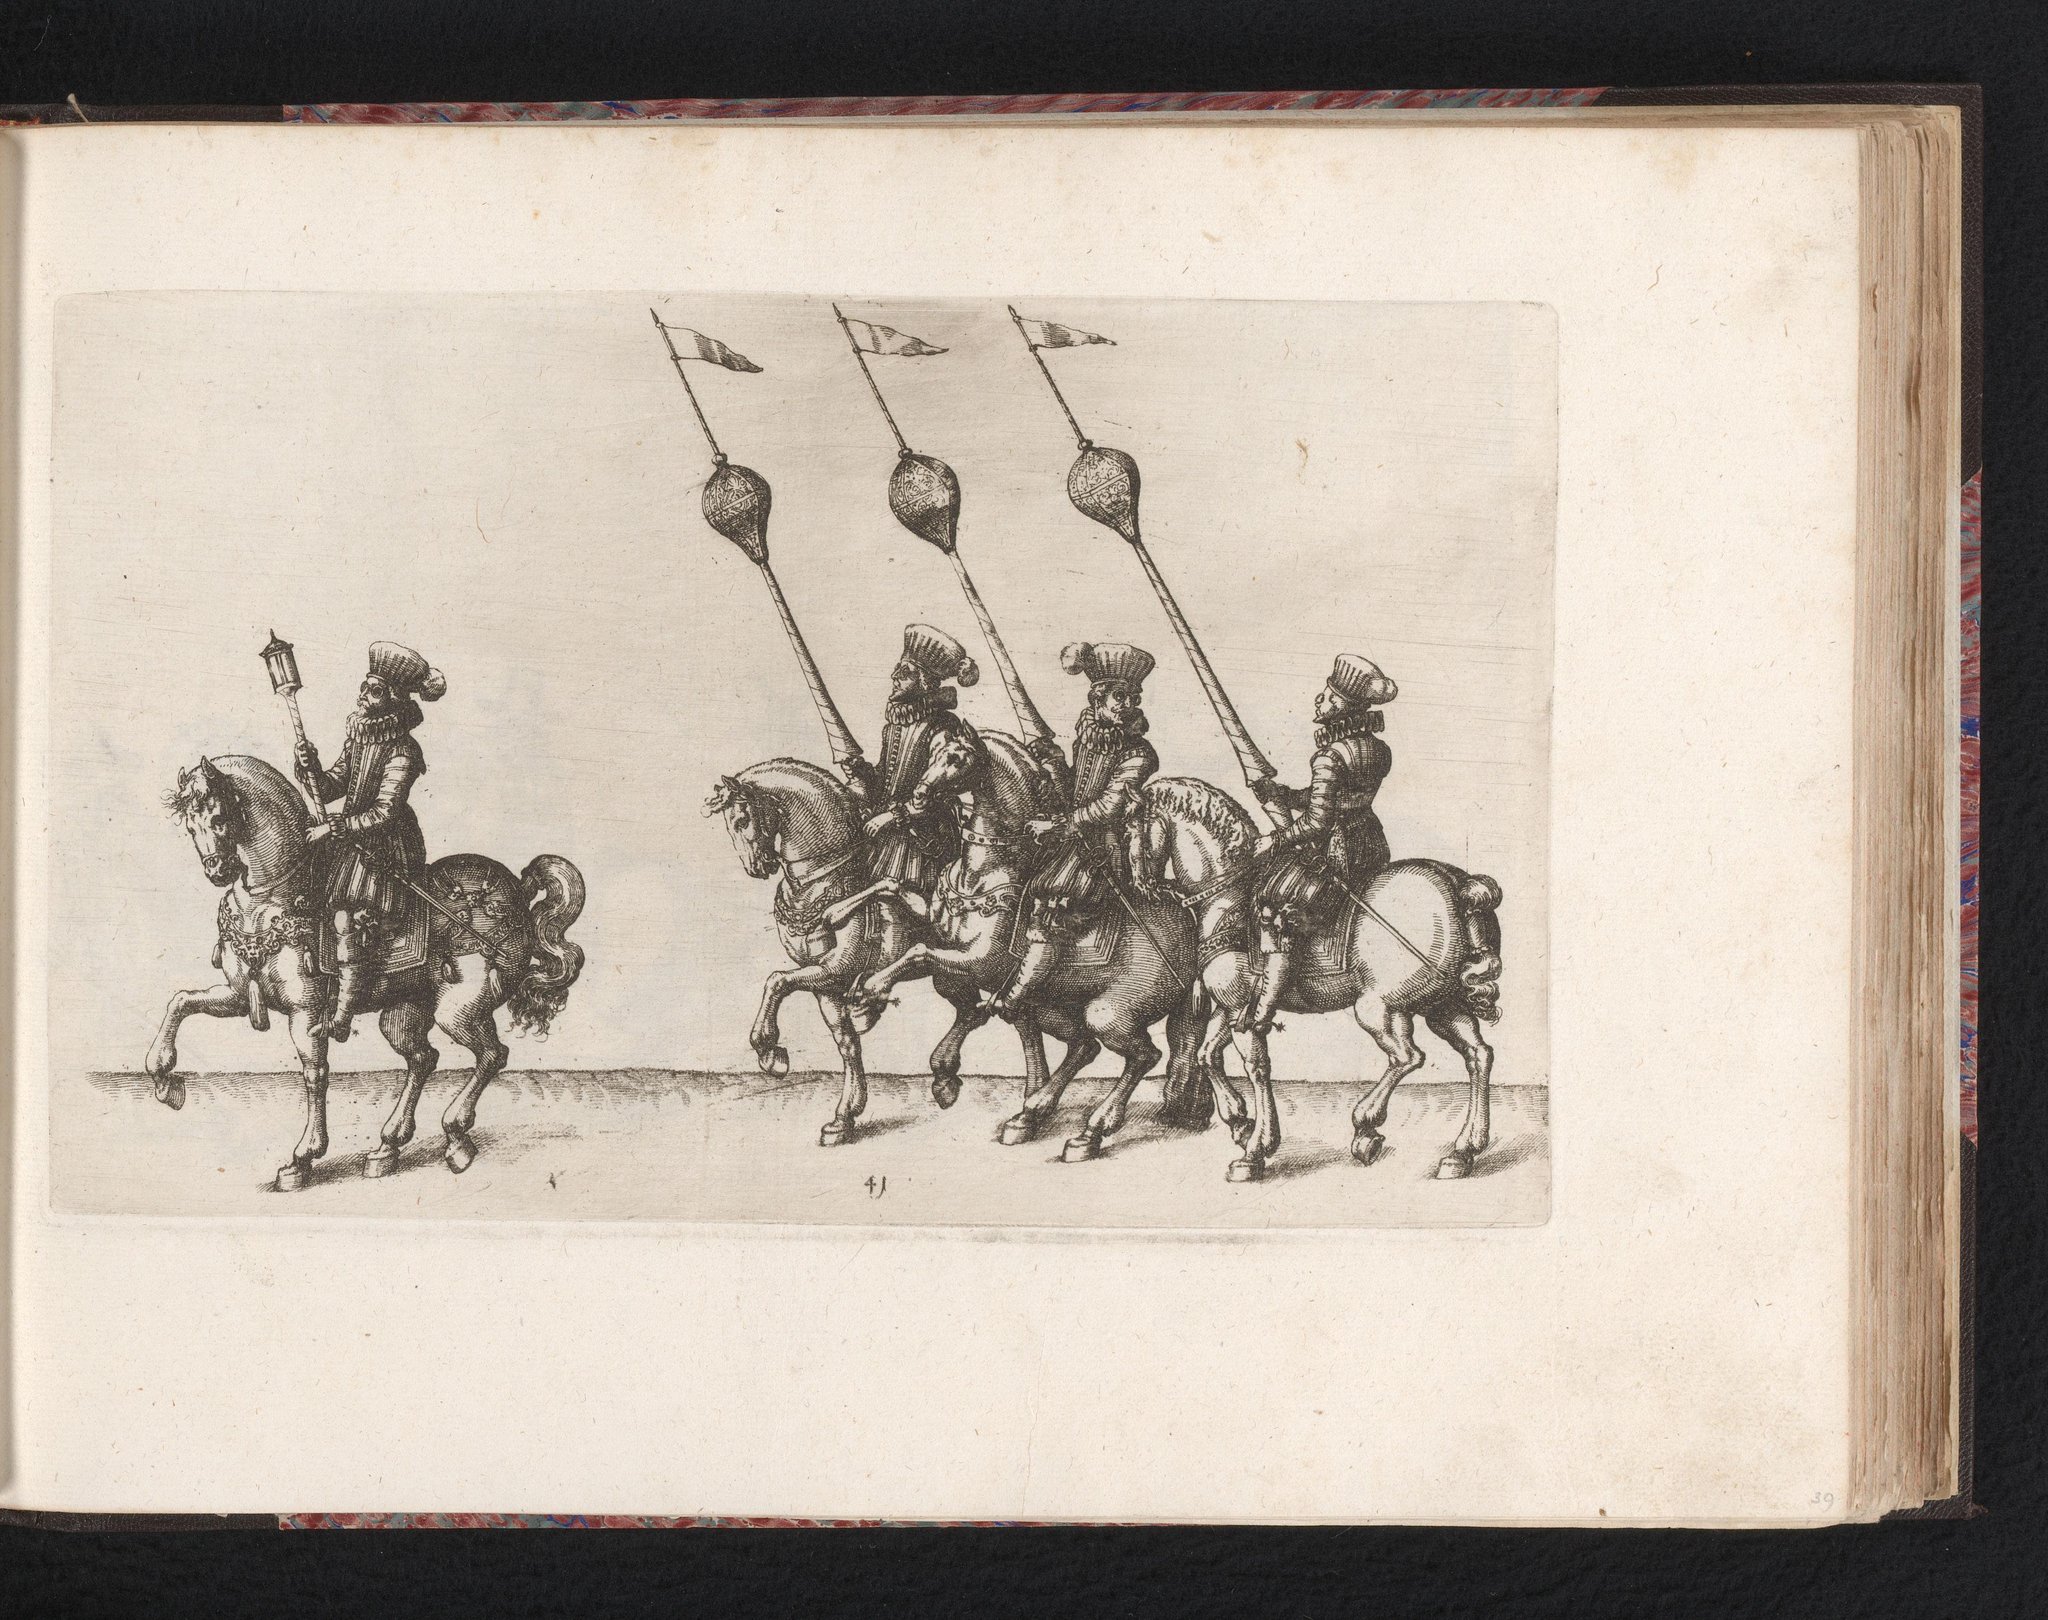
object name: album leaf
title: Aigentliche wahrhaffte Delineation unnd Abbildung aller fürstlichen Auffzüg und Rütterspilen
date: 1618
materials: paper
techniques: etching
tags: eyeglasses, spectacles, torch, performance in the open air (pleasure fair), lantern, lute, and special forms of lute, e.g.: theorbo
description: Genummerd: 40. Deze prent maakt deel uit van een album.